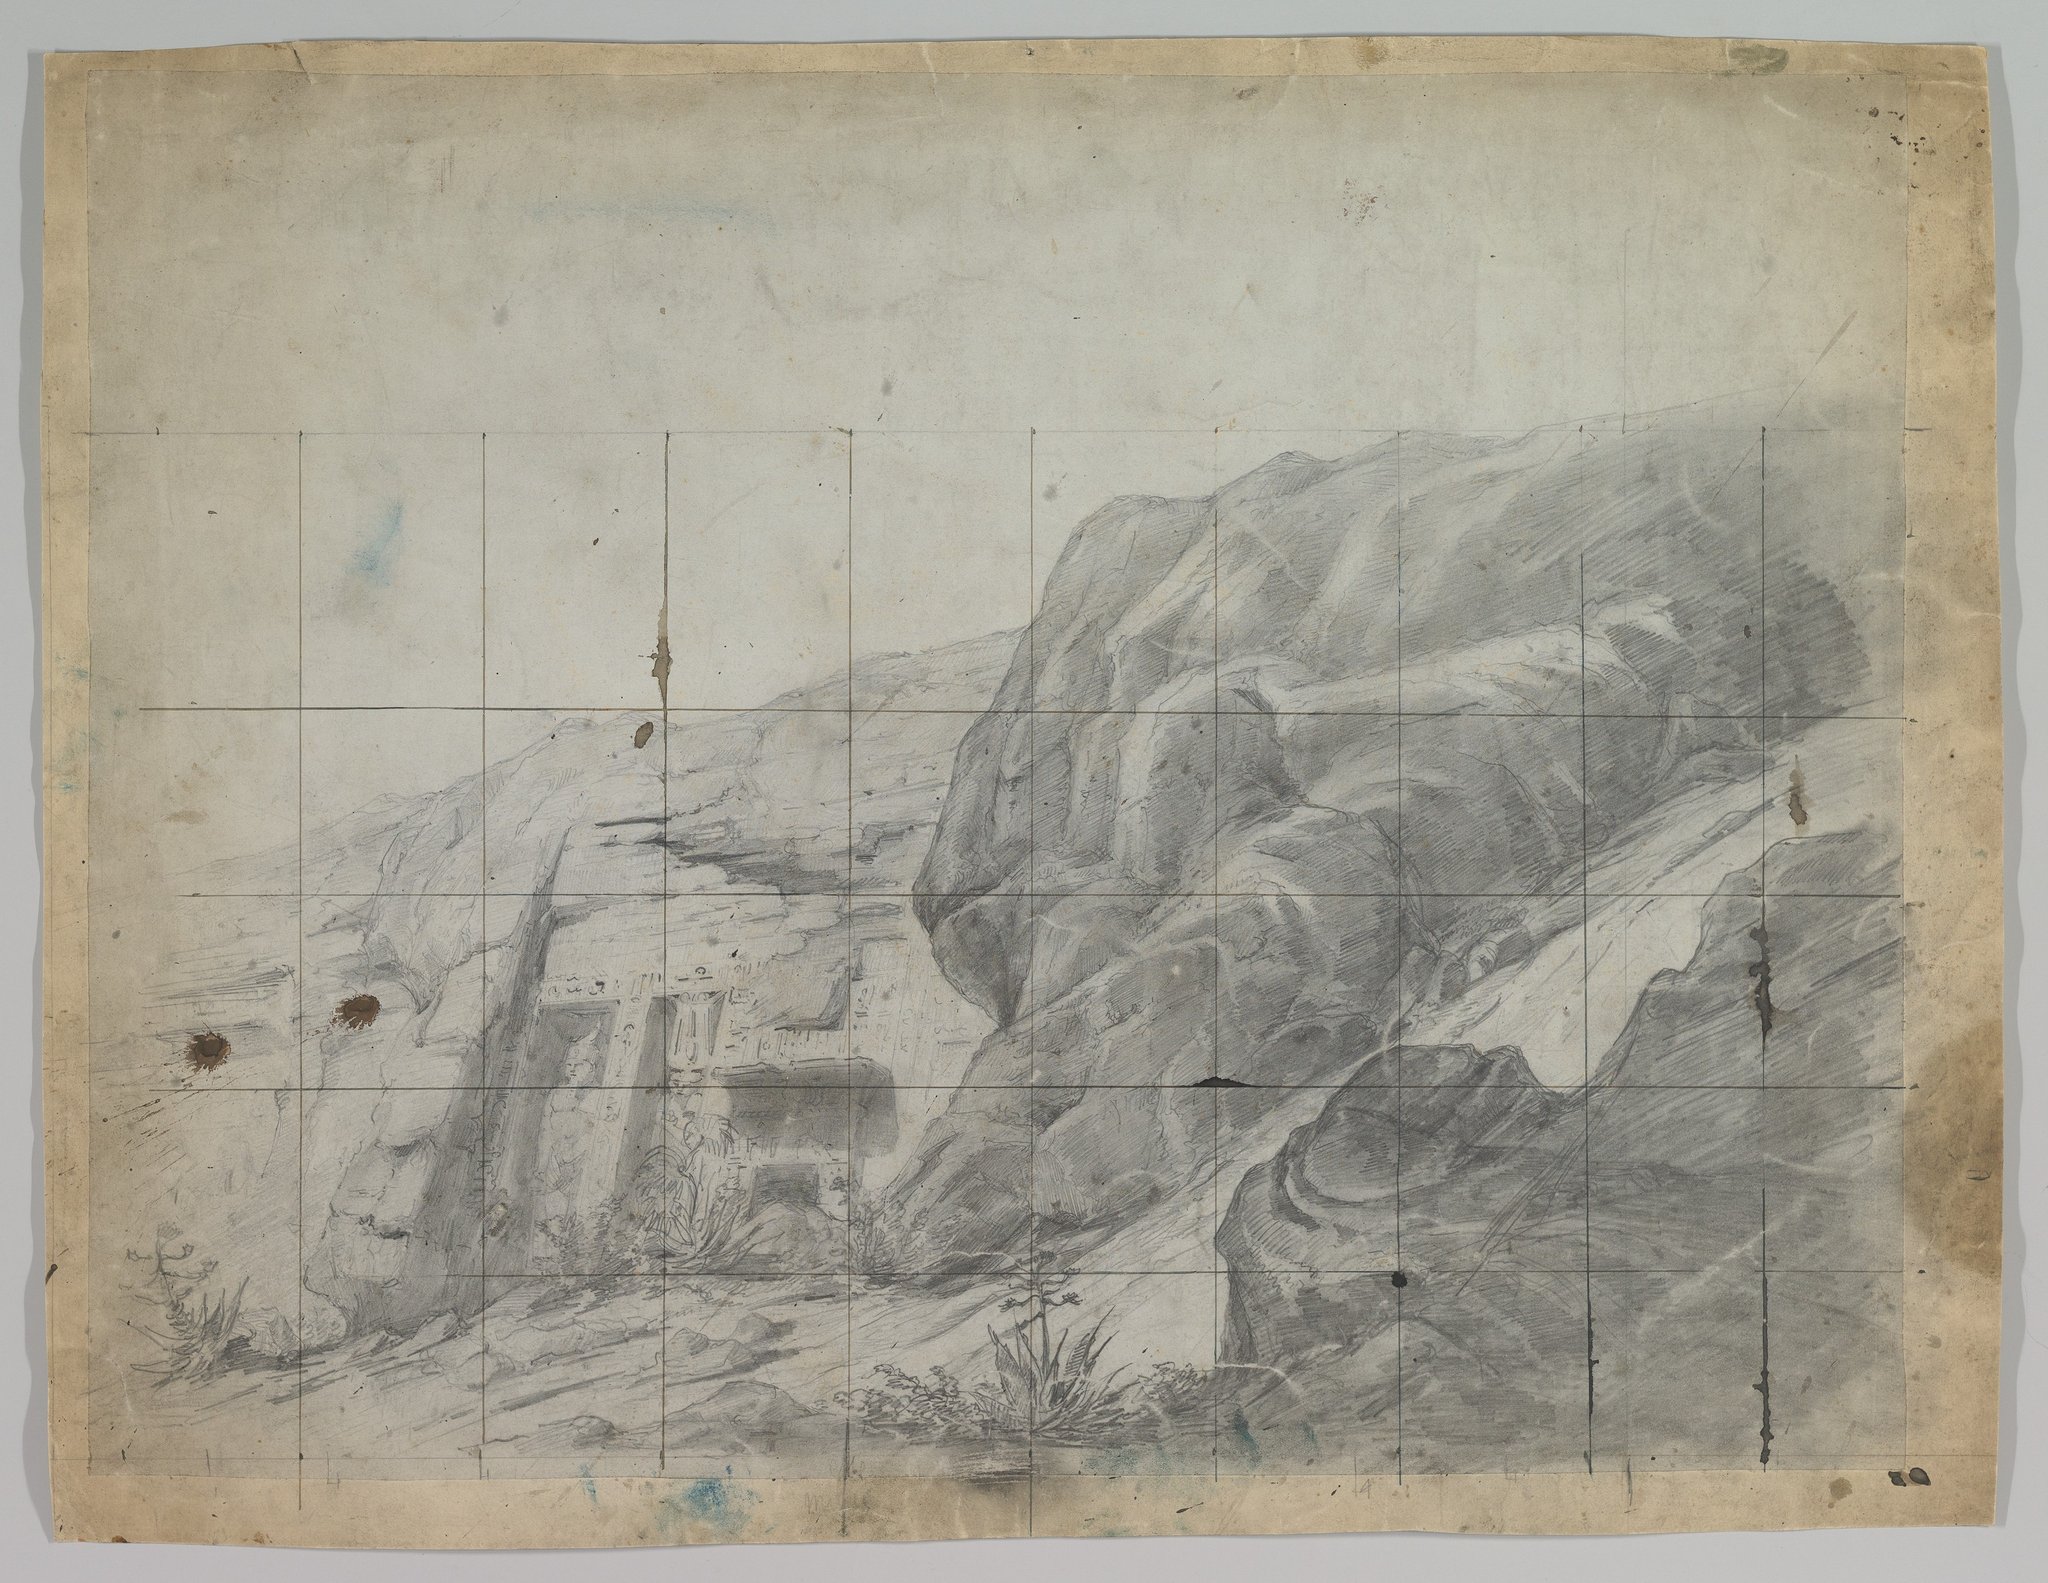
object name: drawing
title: Design for a Stage Set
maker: eugène cicéri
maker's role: artist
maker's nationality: french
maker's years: 1813-1890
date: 1830-1890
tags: mountains,stage design